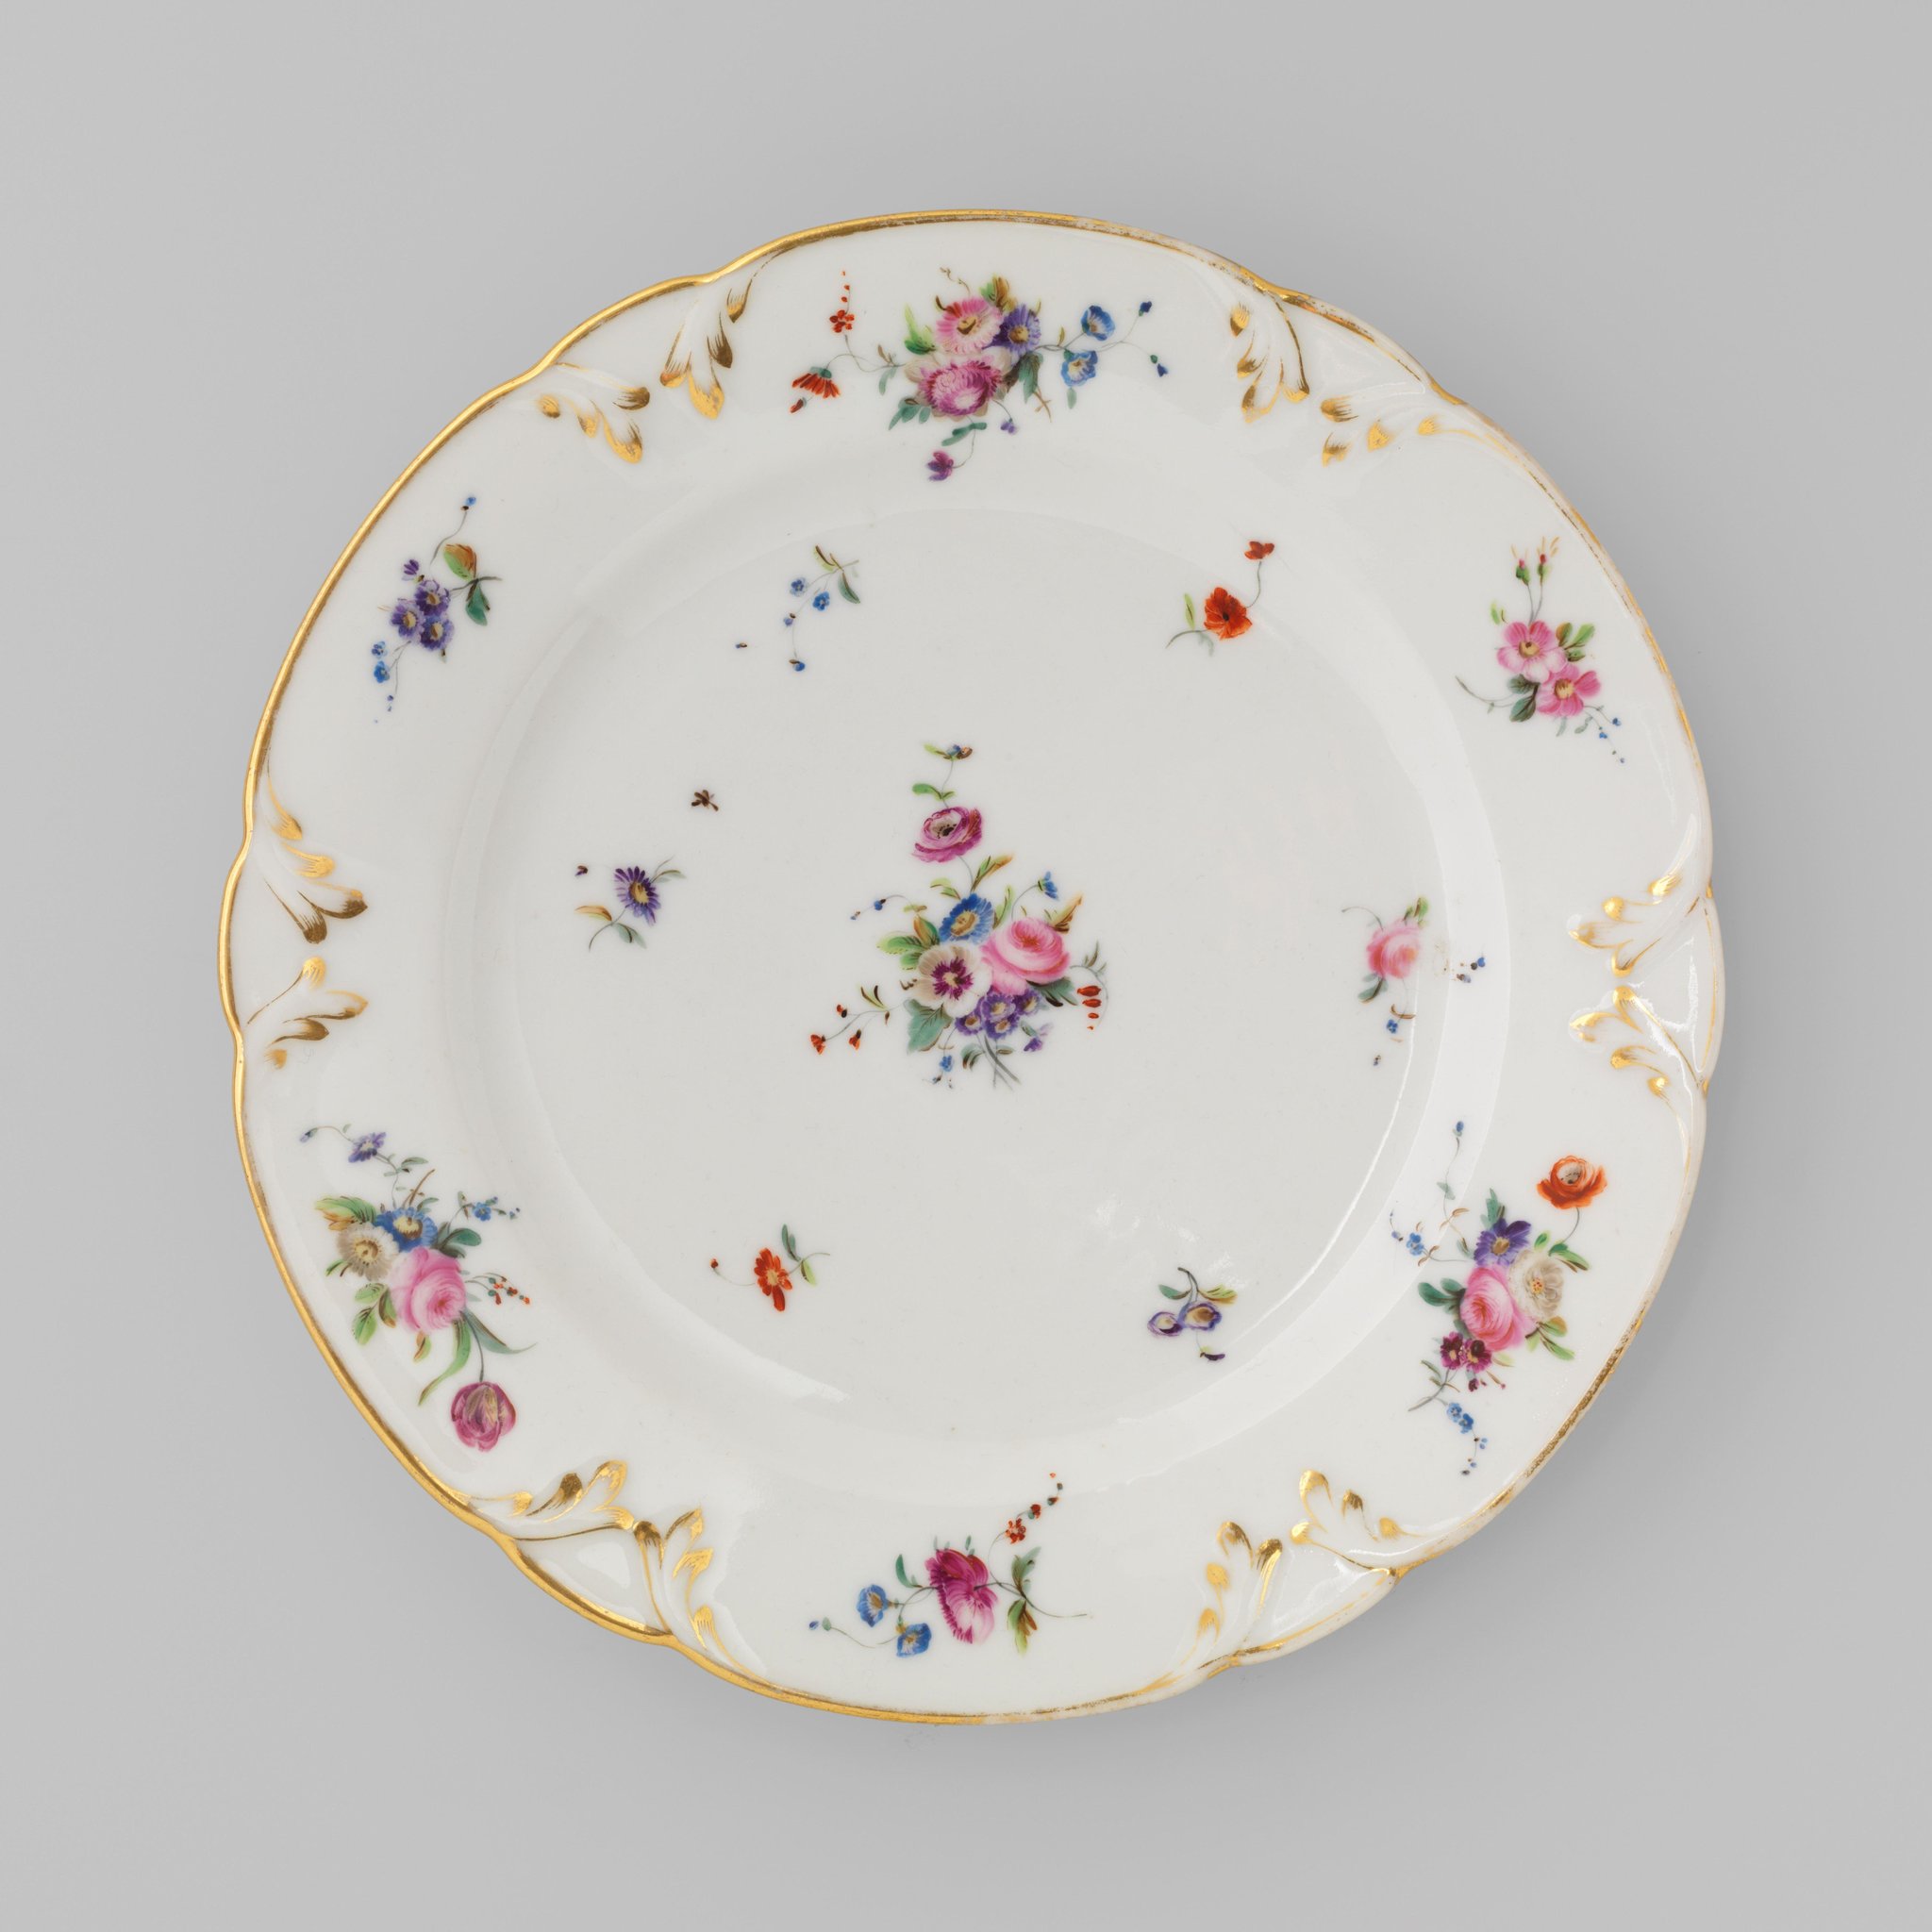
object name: plate dish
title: Plate with bouquets and flower sprays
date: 1839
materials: glaze, gold, paint, porcelain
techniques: firing, forming, gilding, turning, vitrification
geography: paris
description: Bord van porselein met een gelobde rand, beschilderd op het glazuur in blauw, rood, roze, groen, geel, paars, zwart en goud. Op het plat boeketten van verschillende bloemen en strooibloemen. Vanuit de gelobde, gouden rand, gemodelleerde bladranken in reliëf, aangezet met goud. Hiertussen boeketten. Drie proenen op de onderzijde.